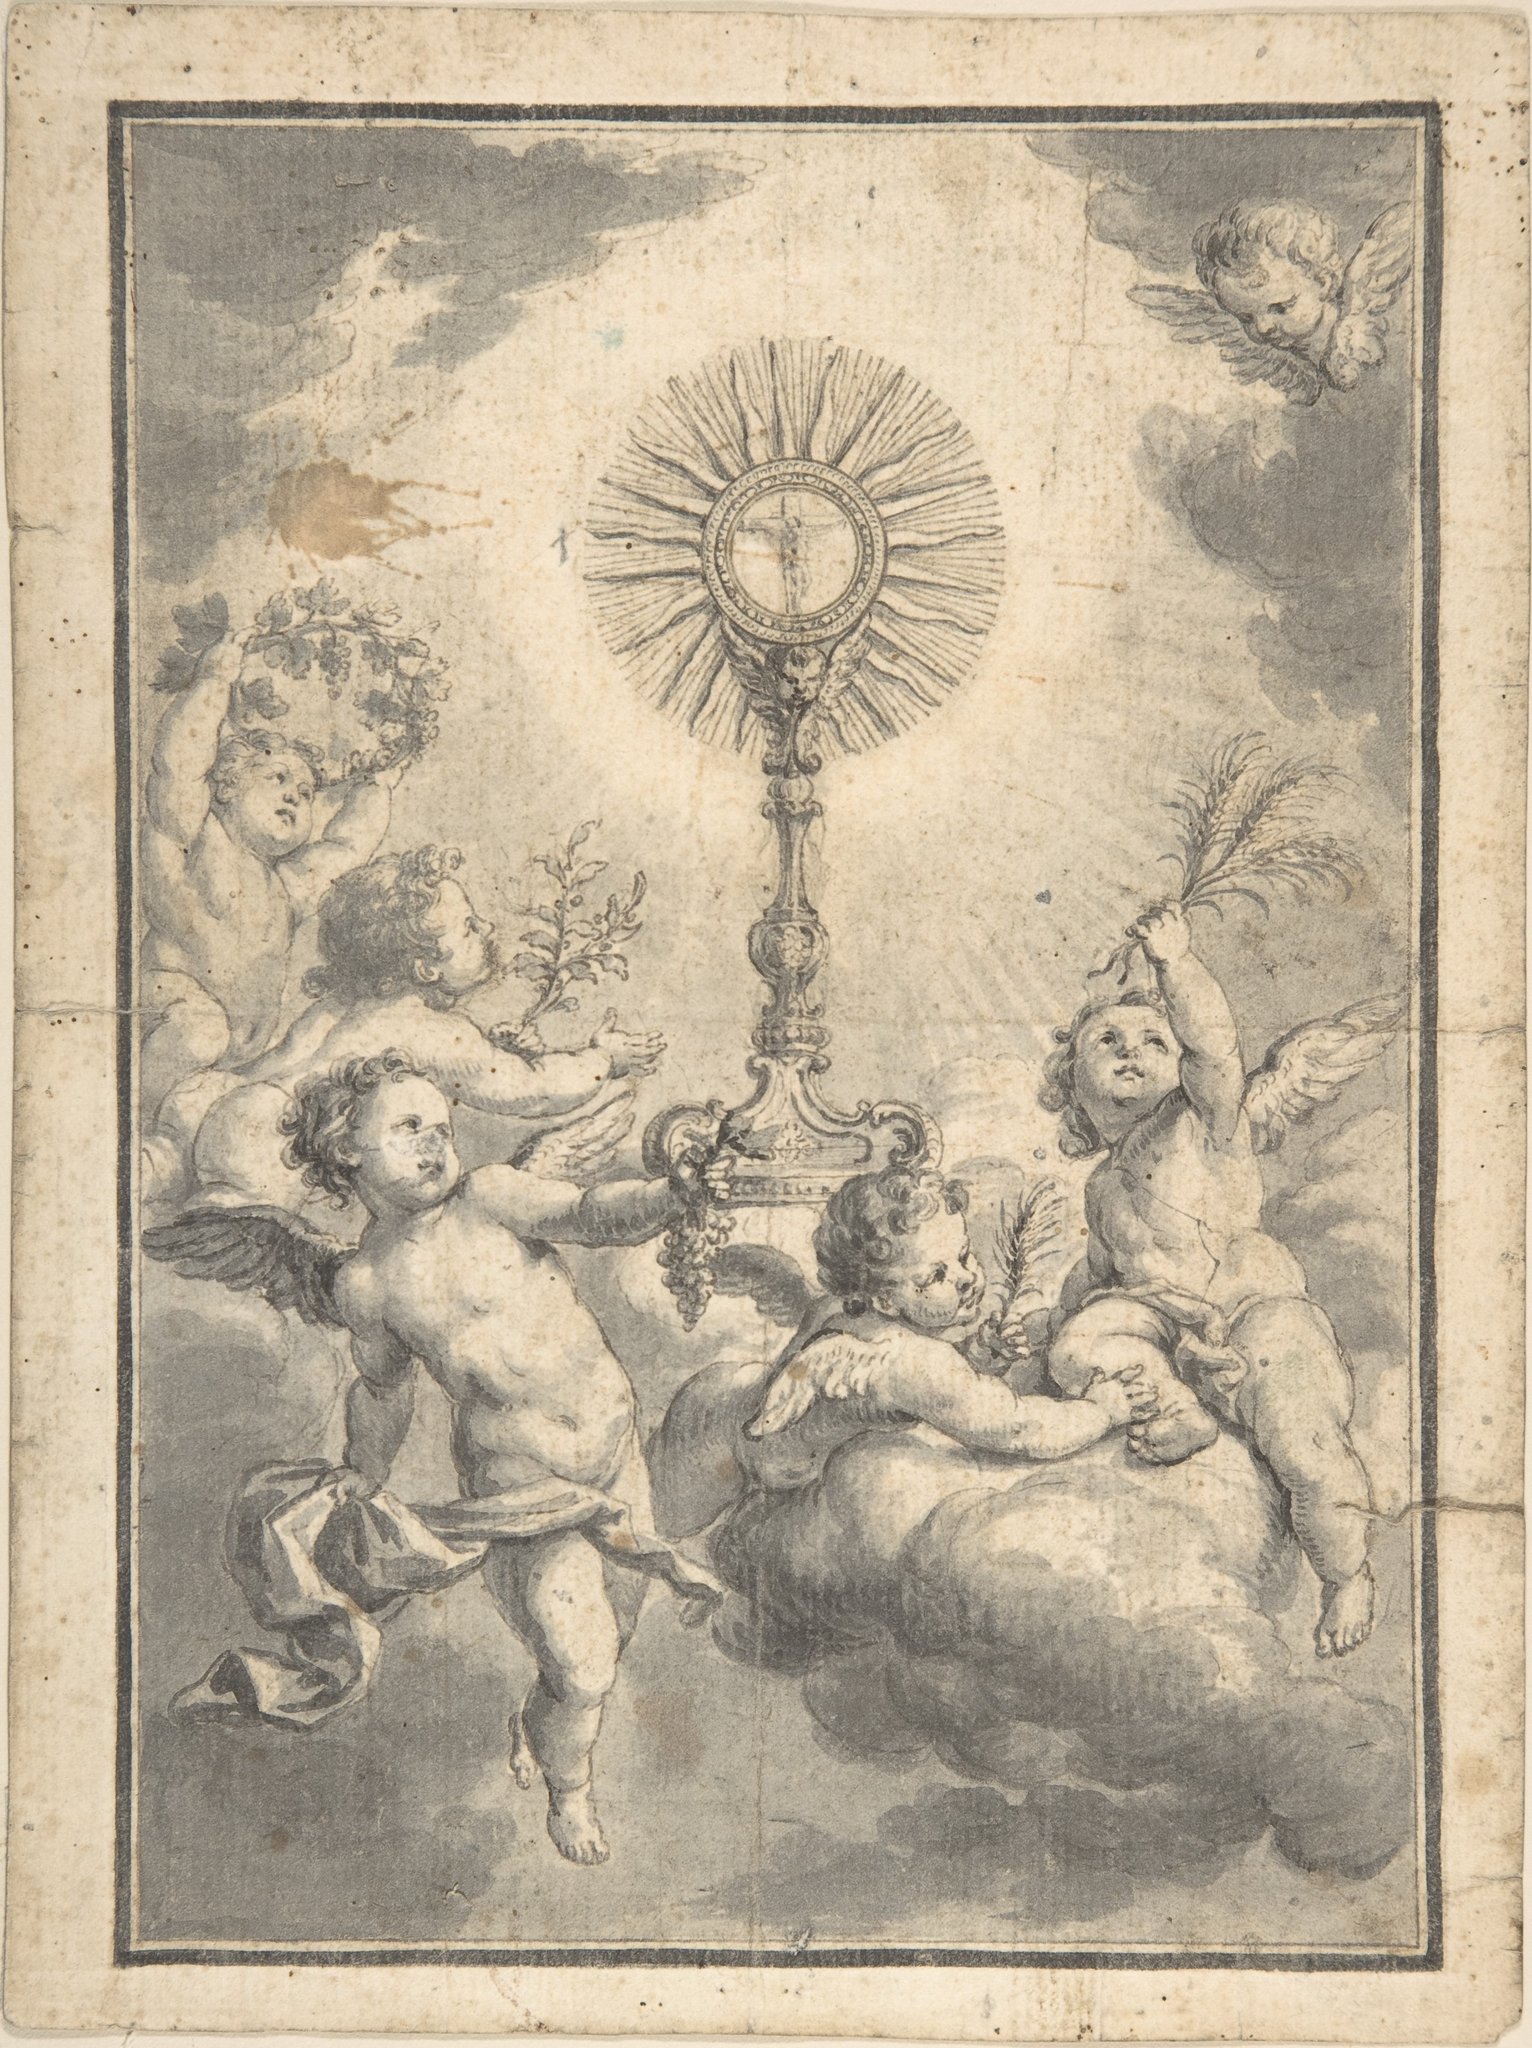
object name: drawing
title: Monstrance Surrounded by Cherubs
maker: anonymous, italian, 17th or 18th century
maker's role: artist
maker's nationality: italian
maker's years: 1600-1799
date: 1600-1800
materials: ink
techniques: grisaille